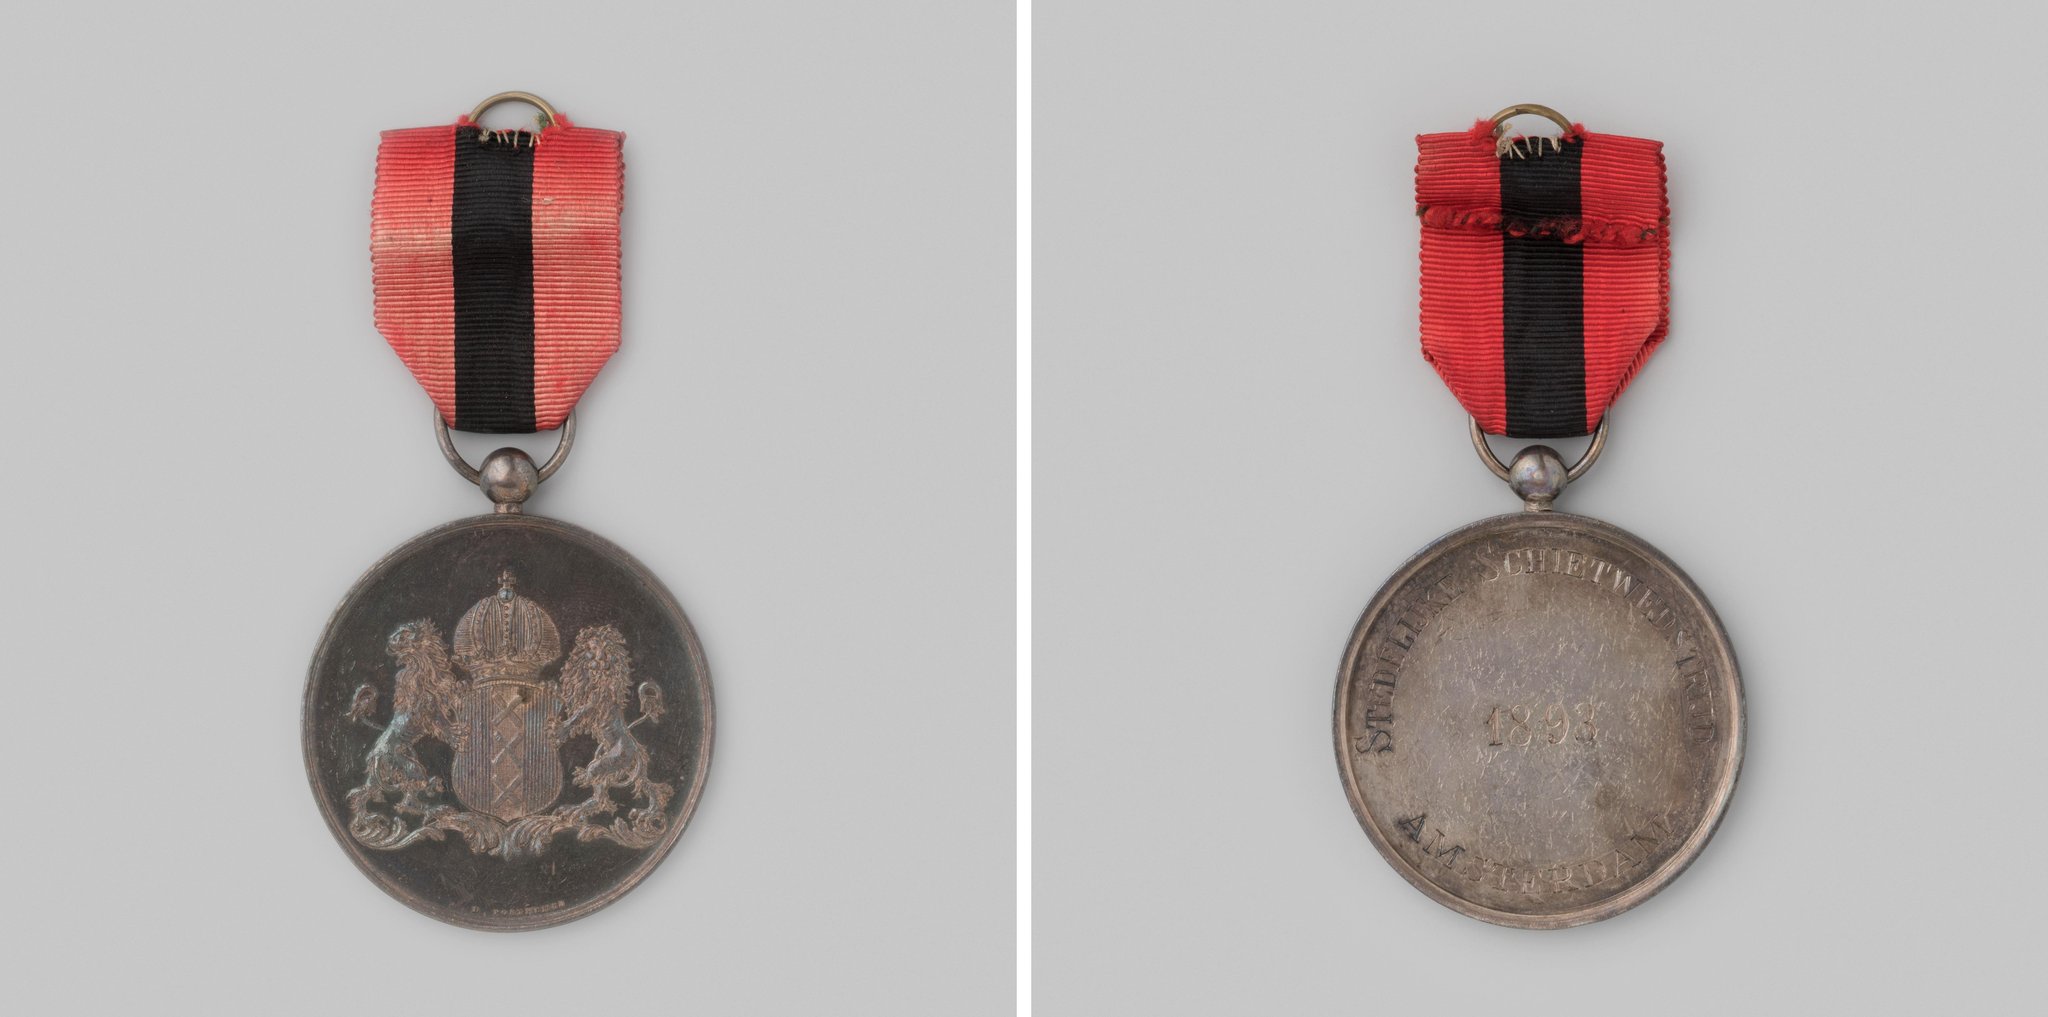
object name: draagpenning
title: Prijspenning van de Nederlandsche Schutterij Kaderbond, Stedelijke Schietwedstrijd te Amsterdam, 1893, behaald door de afdeling Amsterdam, individueel vuur, eerste prijs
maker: Anonymous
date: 1893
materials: silver, textile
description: Zilveren draagpenning met knop, ring en lint.